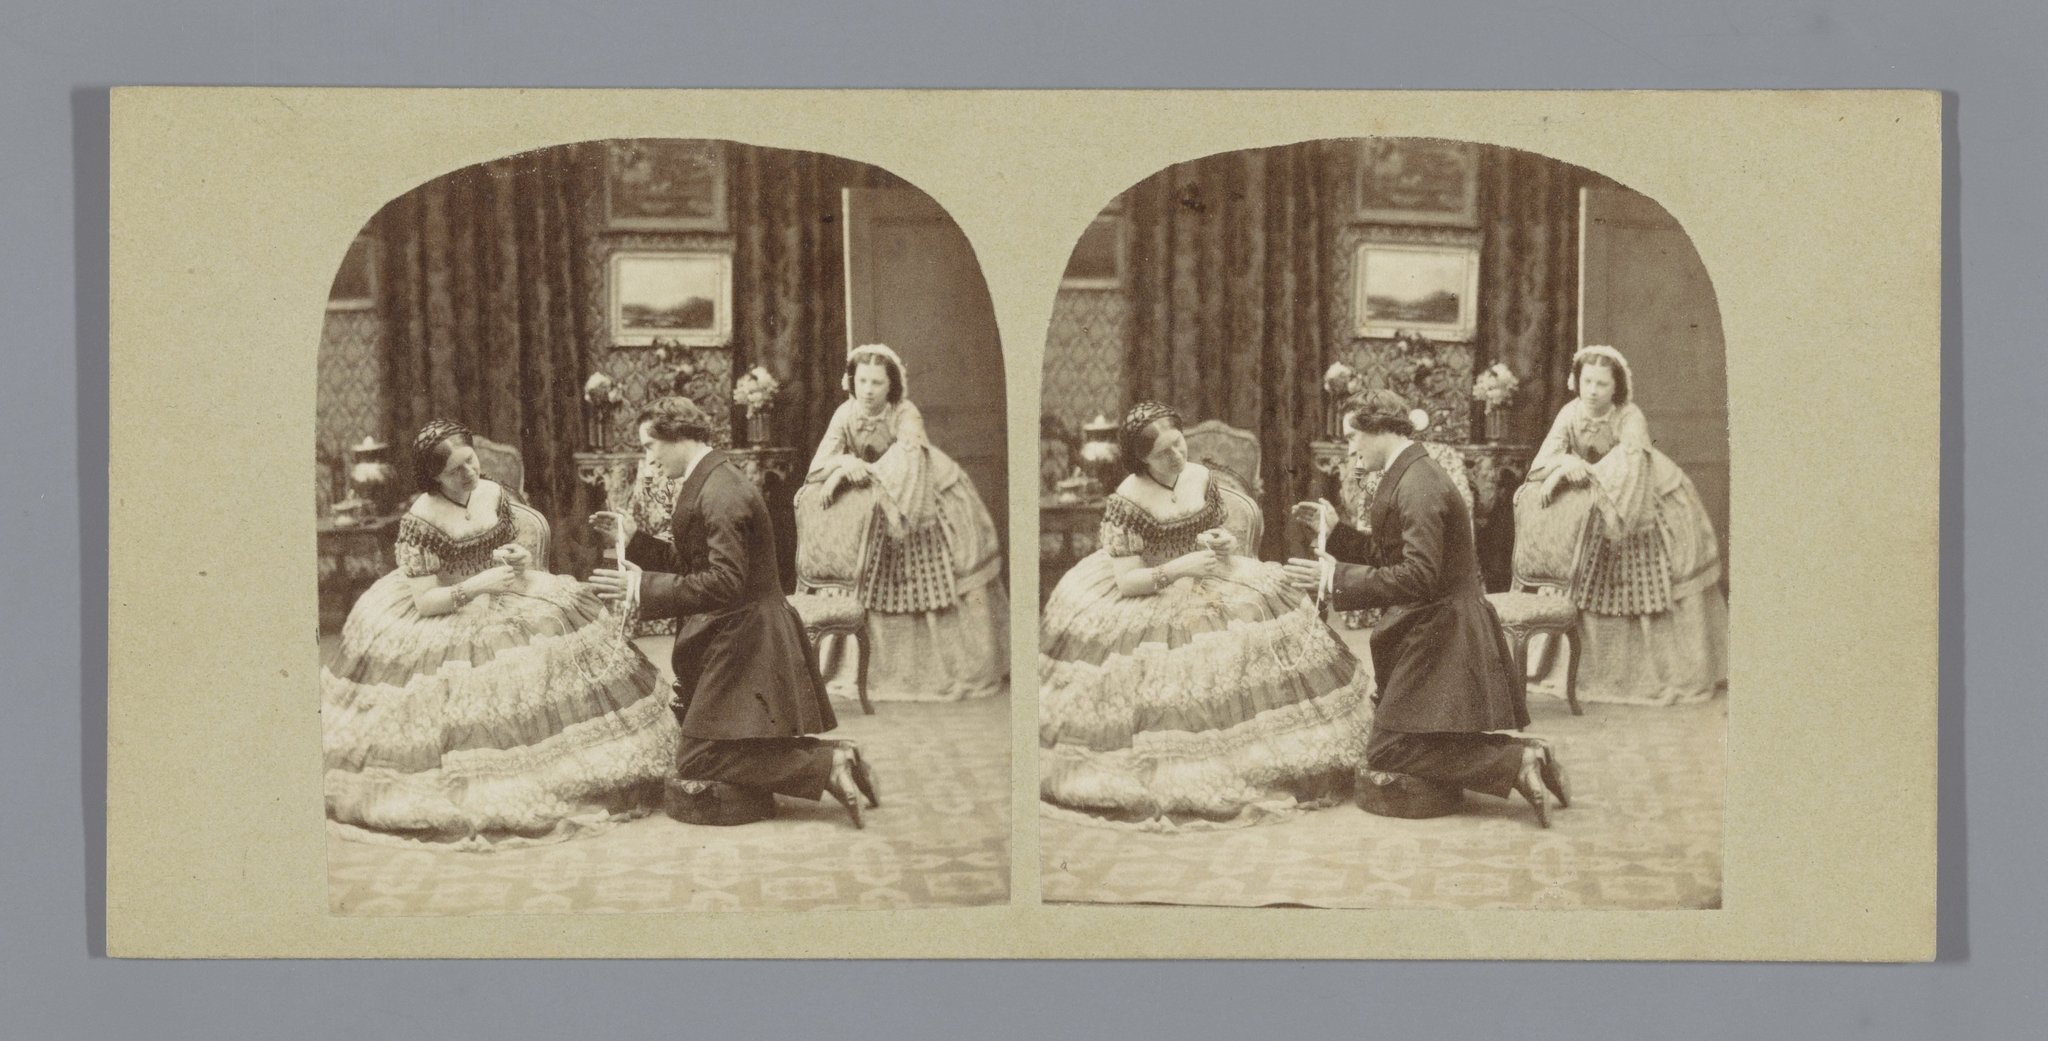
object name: stereograph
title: Man en een vrouw winden een draad wol op, op achtergrond kijkt een tweede vrouw toe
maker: Anonymous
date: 1850-1880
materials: cardboard, photographic support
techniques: albumen print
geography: europe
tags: wool (material ~ textile industry), europe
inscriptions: number: ‘14.’